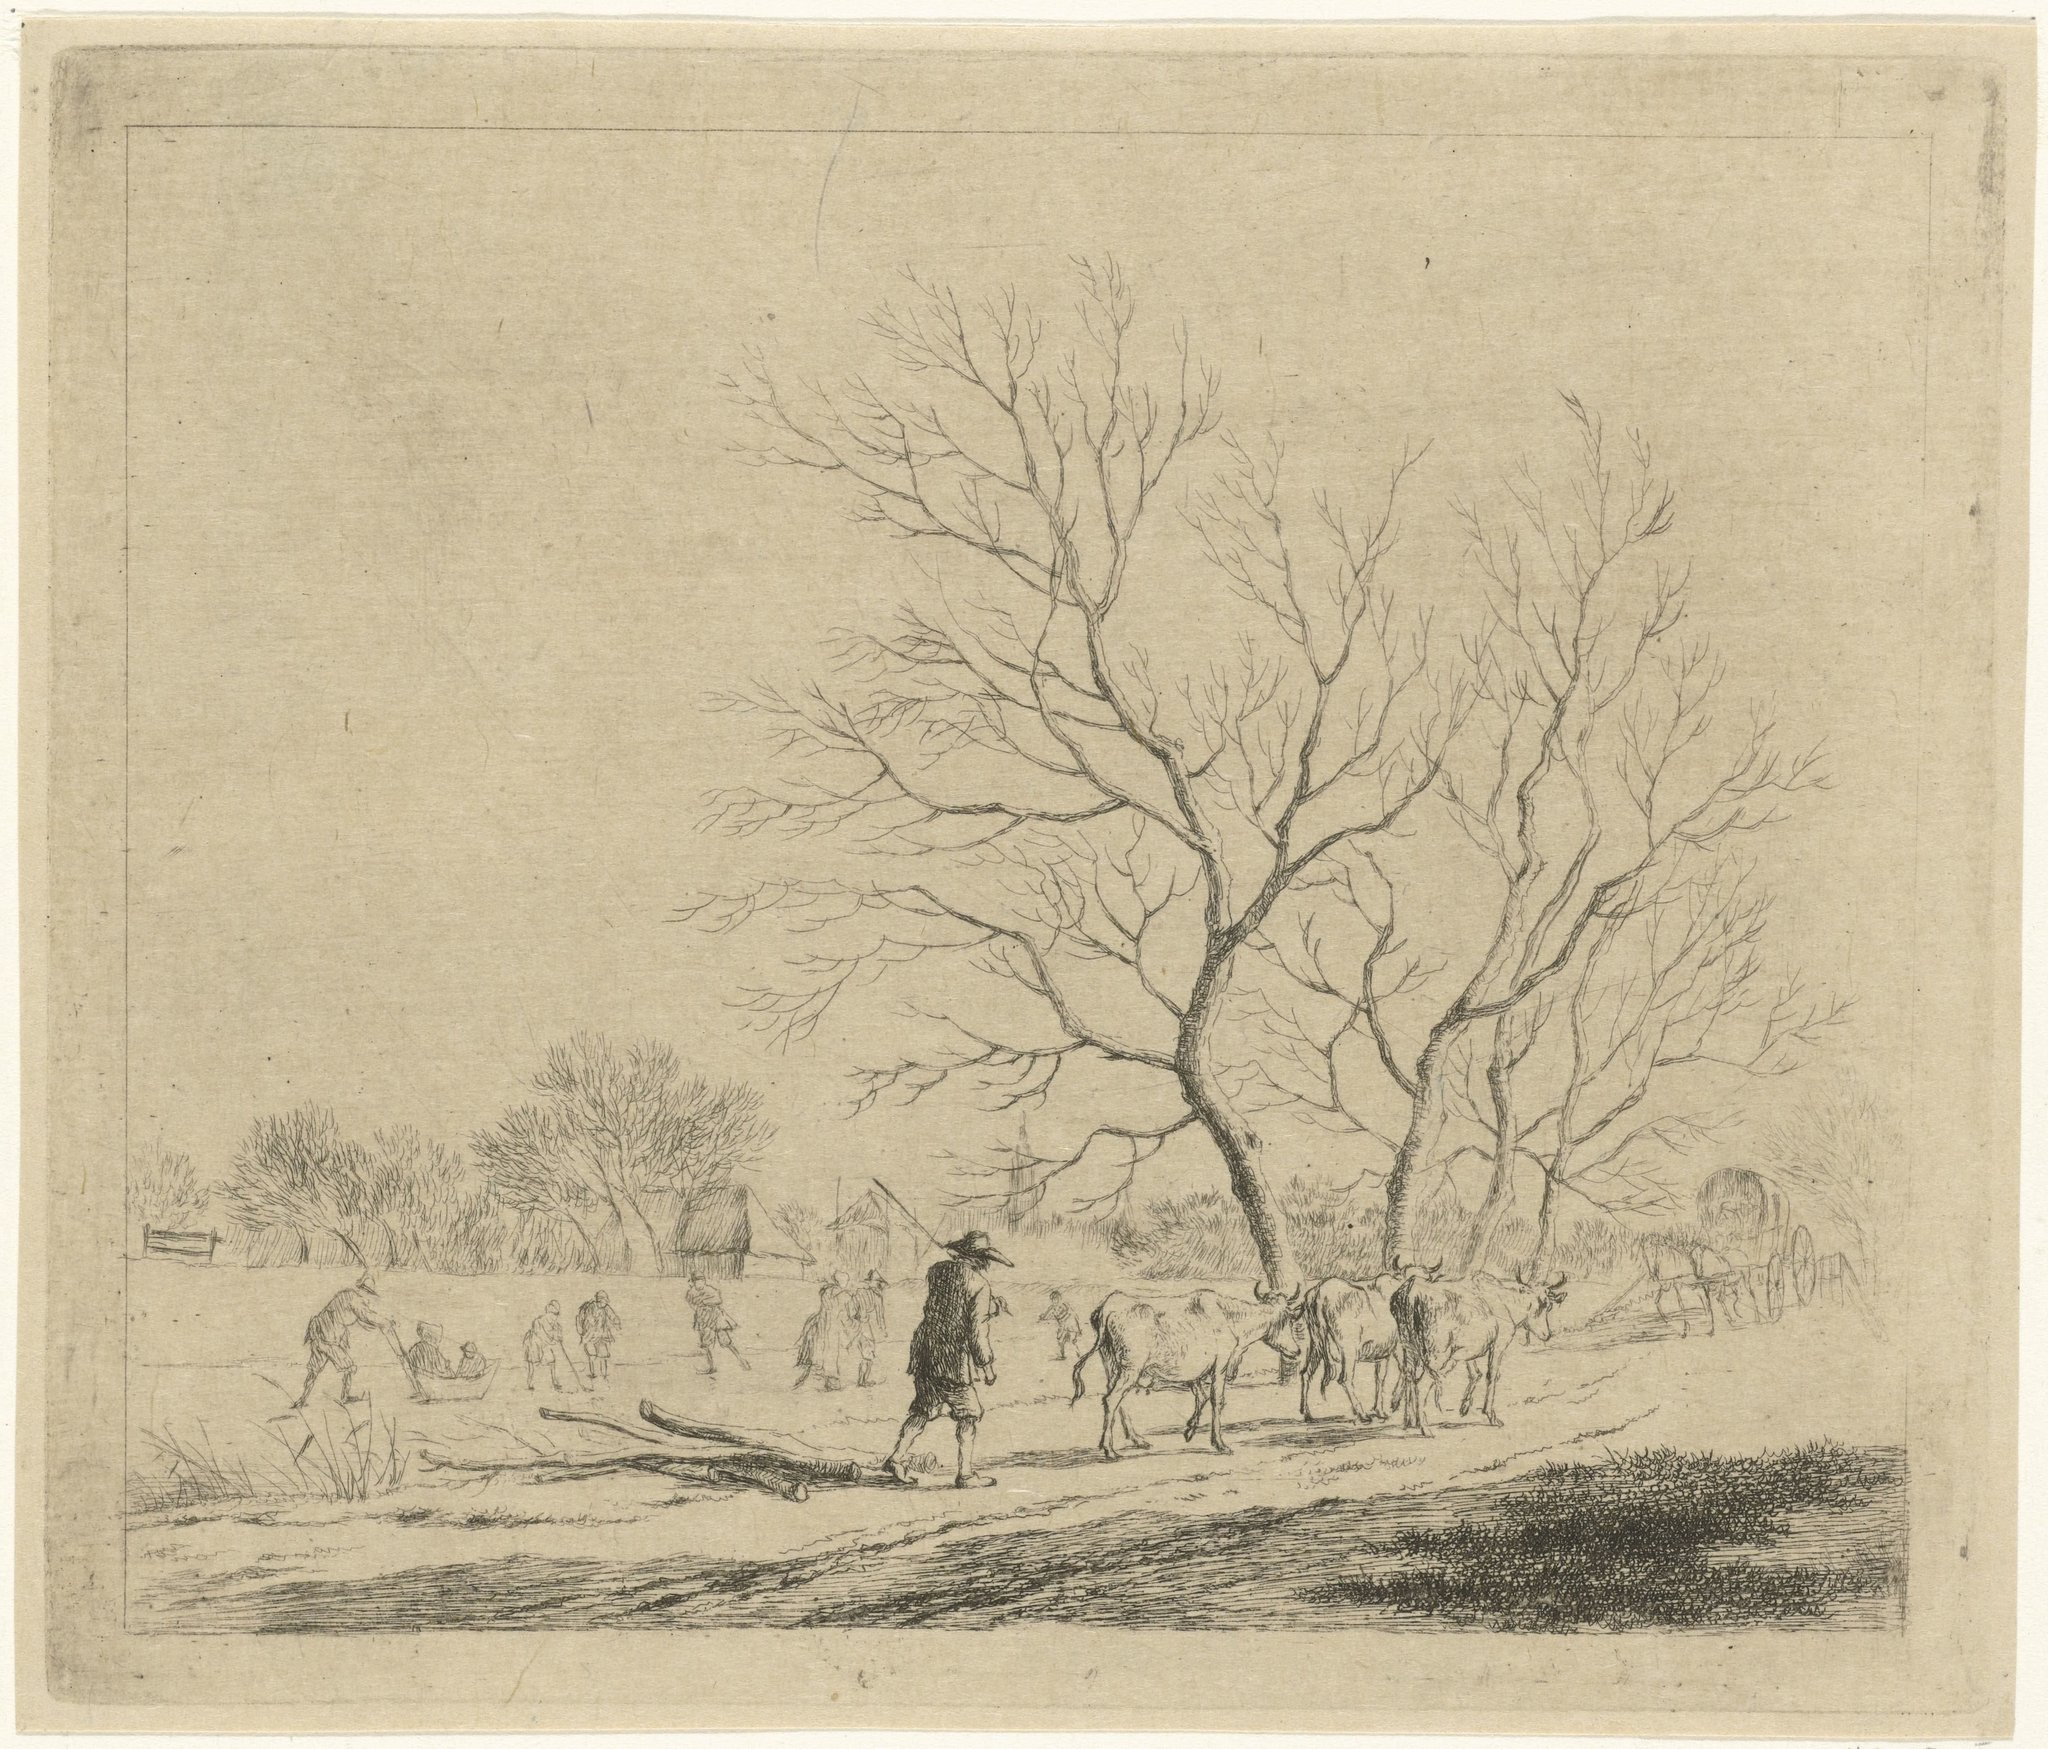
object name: print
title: De twaalf maanden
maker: johannes janson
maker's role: draughtsman, painter, print maker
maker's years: 1729-1784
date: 1783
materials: paper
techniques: etching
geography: leiden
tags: landscape symbolizing december, winter ~ human activities (the four seasons of the year)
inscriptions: collector's mark: Lugt 240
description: Winterlandschap met herder met drie koeien op een pad, op de rug gezien. Een huifkar komt hen tegemoet. Links schaatsers op een bevroren rivier. Vóór de lucht. Dertiende prent uit een serie van dertien met maanden.